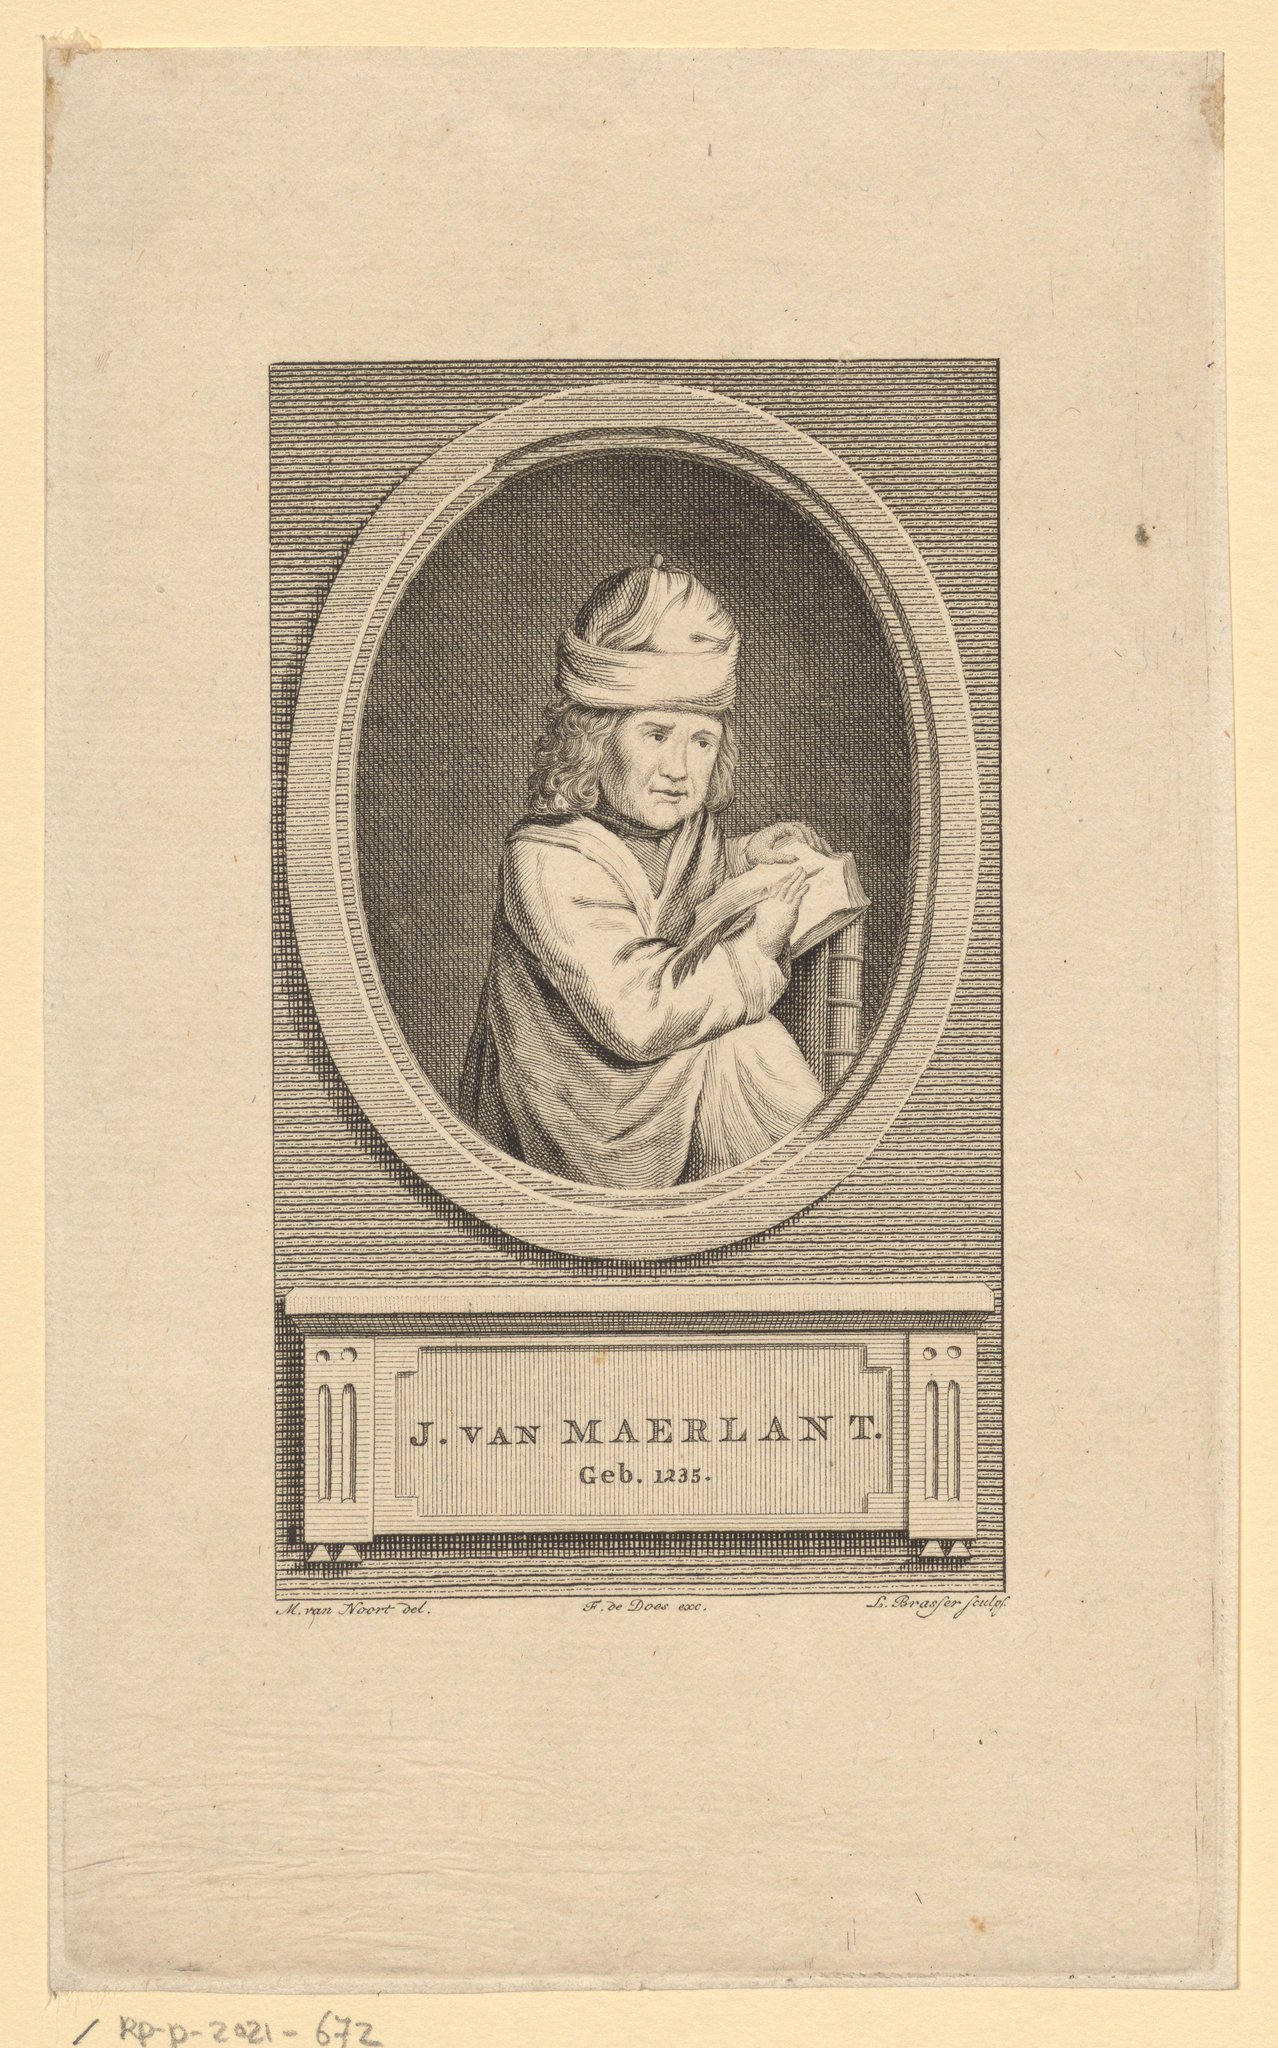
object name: print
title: Portret van Jacob van Maerlant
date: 1770-1787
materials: paper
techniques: engraving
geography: leiden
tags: historical persons, writer, poet, author